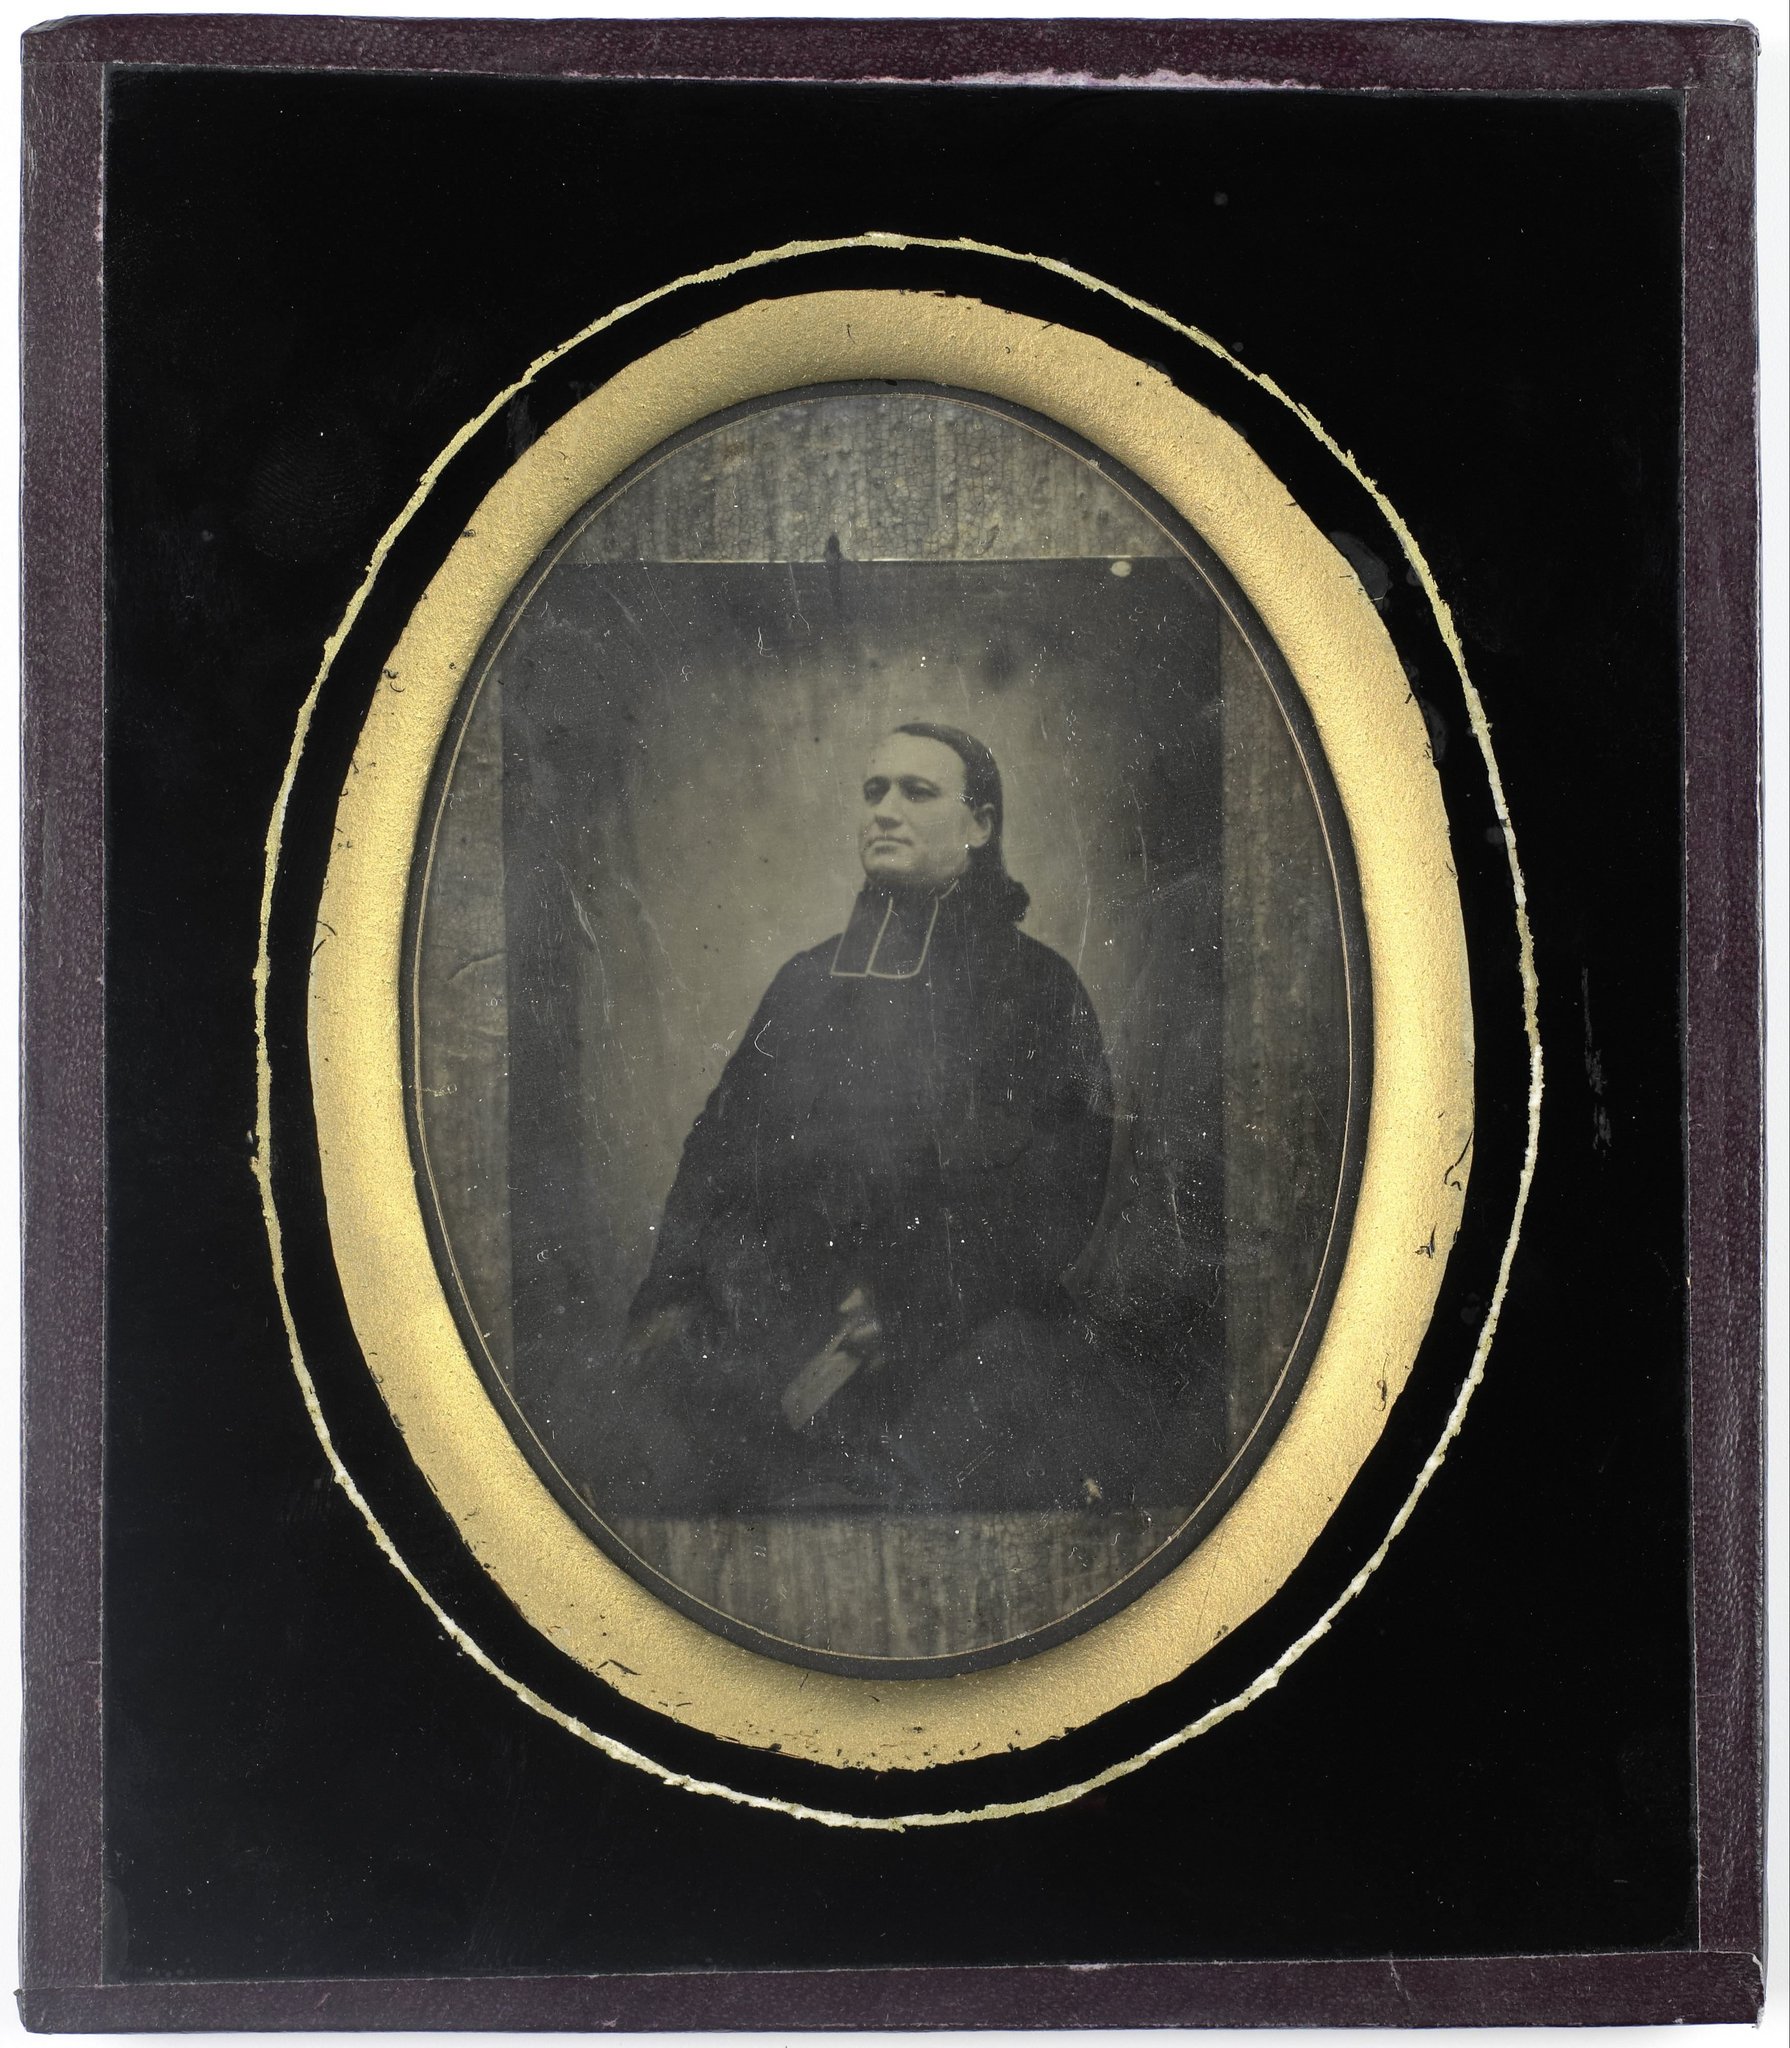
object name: photograph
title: Portret van een onbekende man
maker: leroux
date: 1860-1880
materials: copper, glass, paper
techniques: daguerreotype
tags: adult man, historical persons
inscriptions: inscription: ‘Porteus av. dag/ exécutes oar Leroux [...] Au Grand Bazar Bordelais’